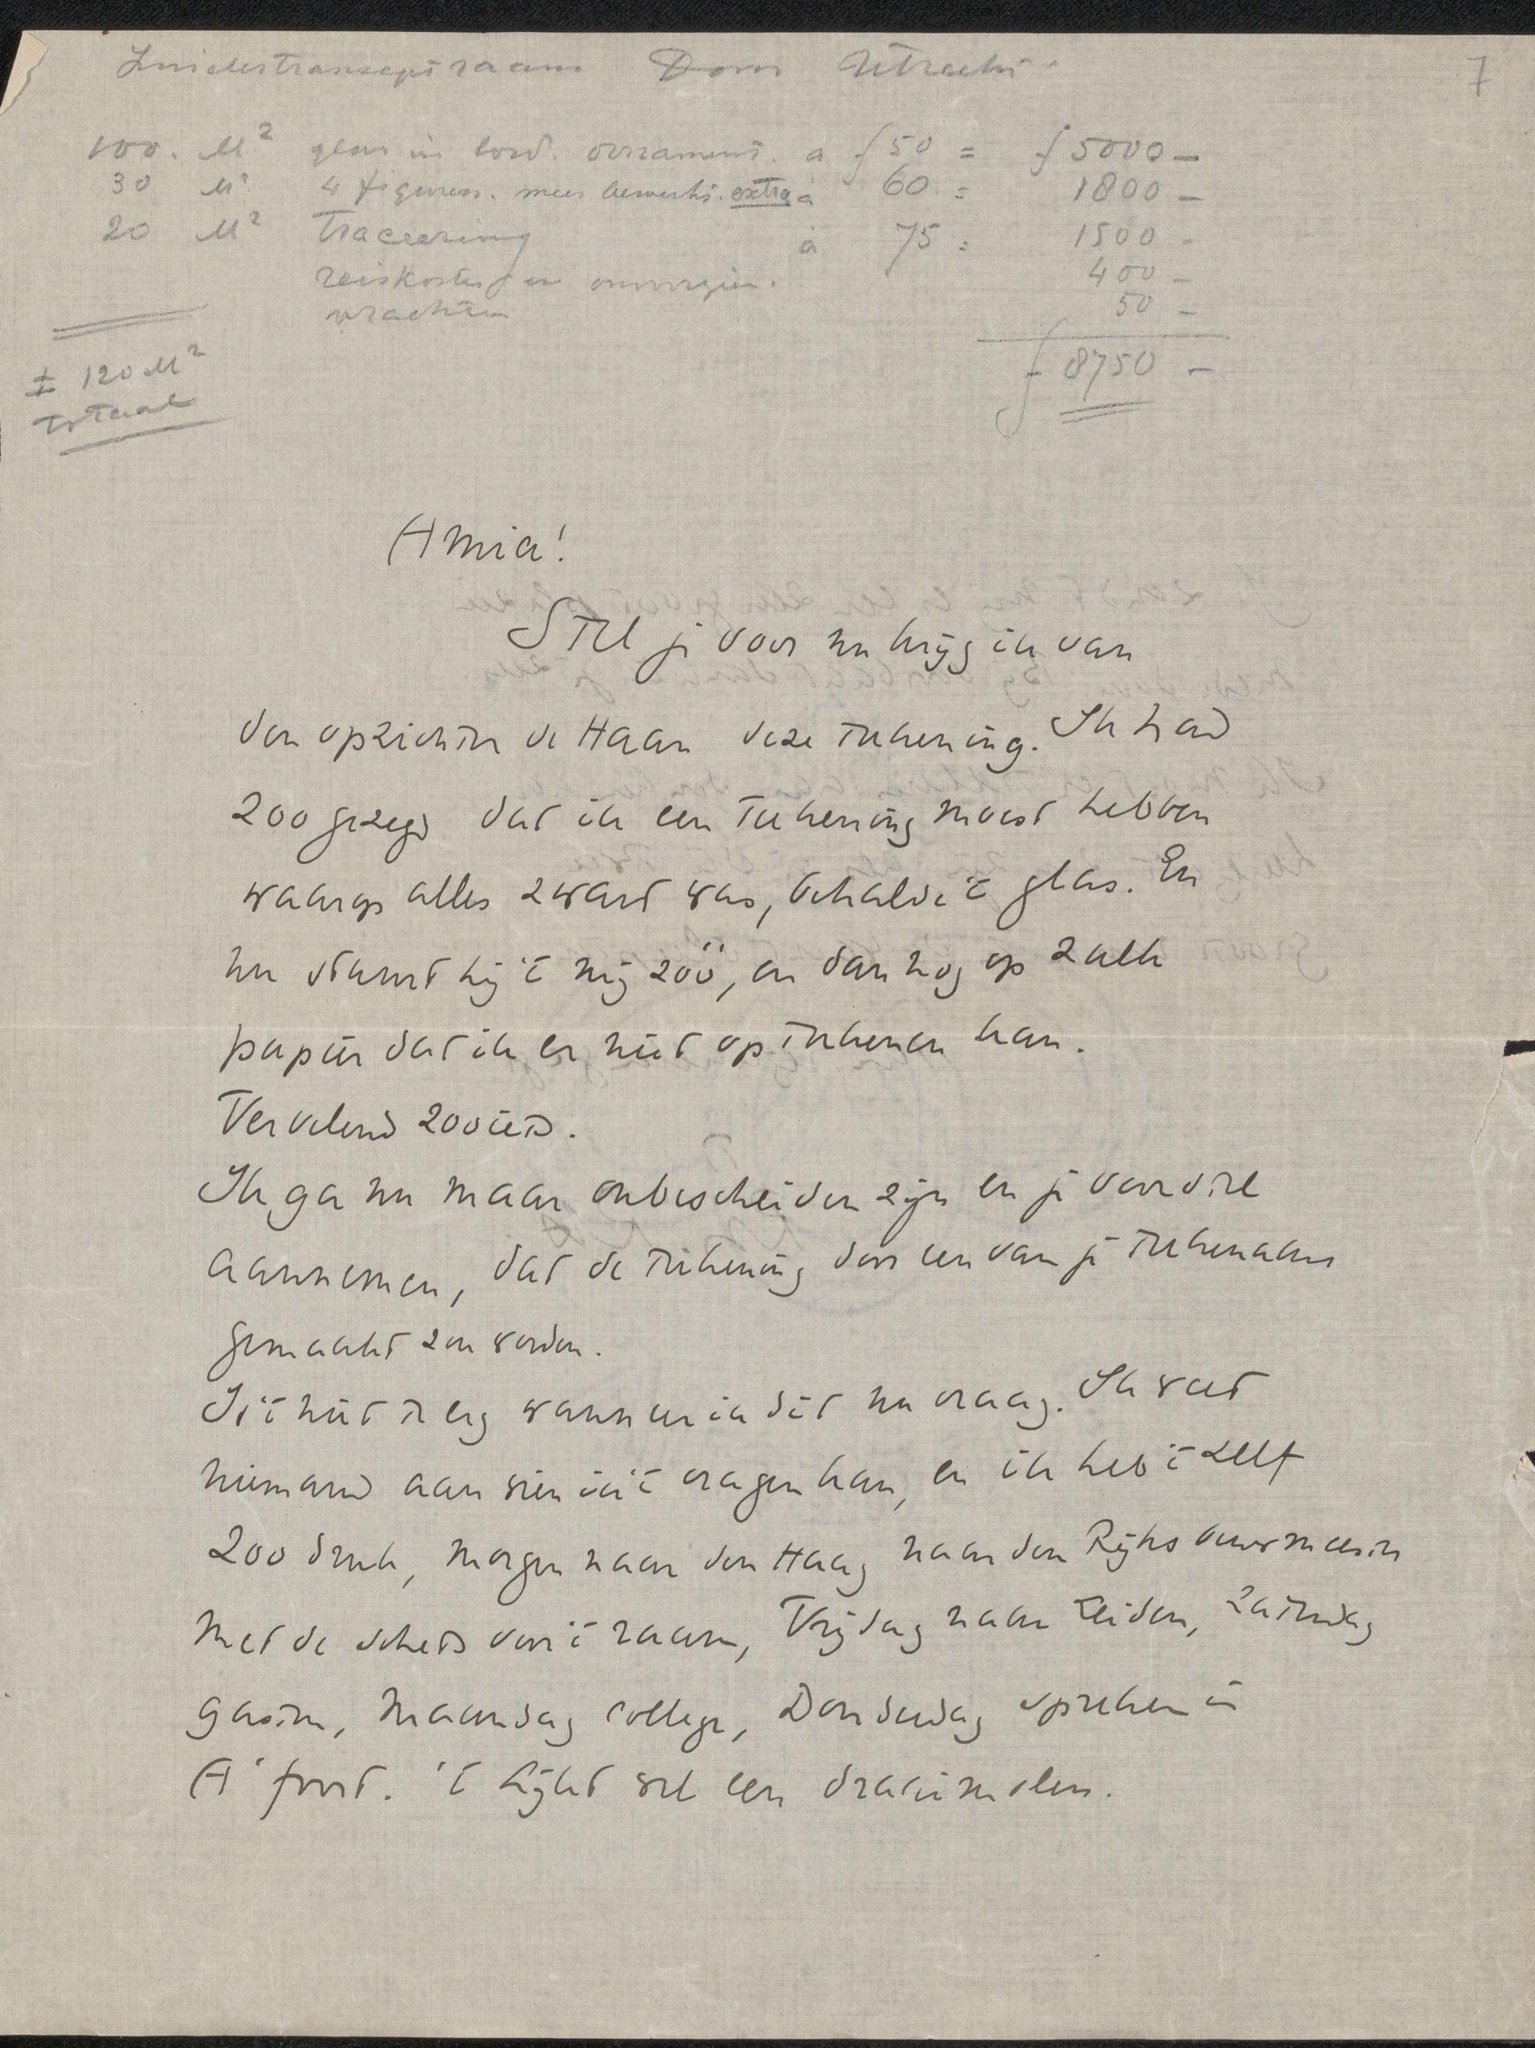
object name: letter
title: Brief aan Willem Bogtman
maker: richard nicolaüs roland holst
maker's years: 1868-1938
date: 1923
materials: ink, paper, pencil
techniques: pen, writing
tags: haarlem, willem bogtman, drawing, money, leiden, the hague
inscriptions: watermark